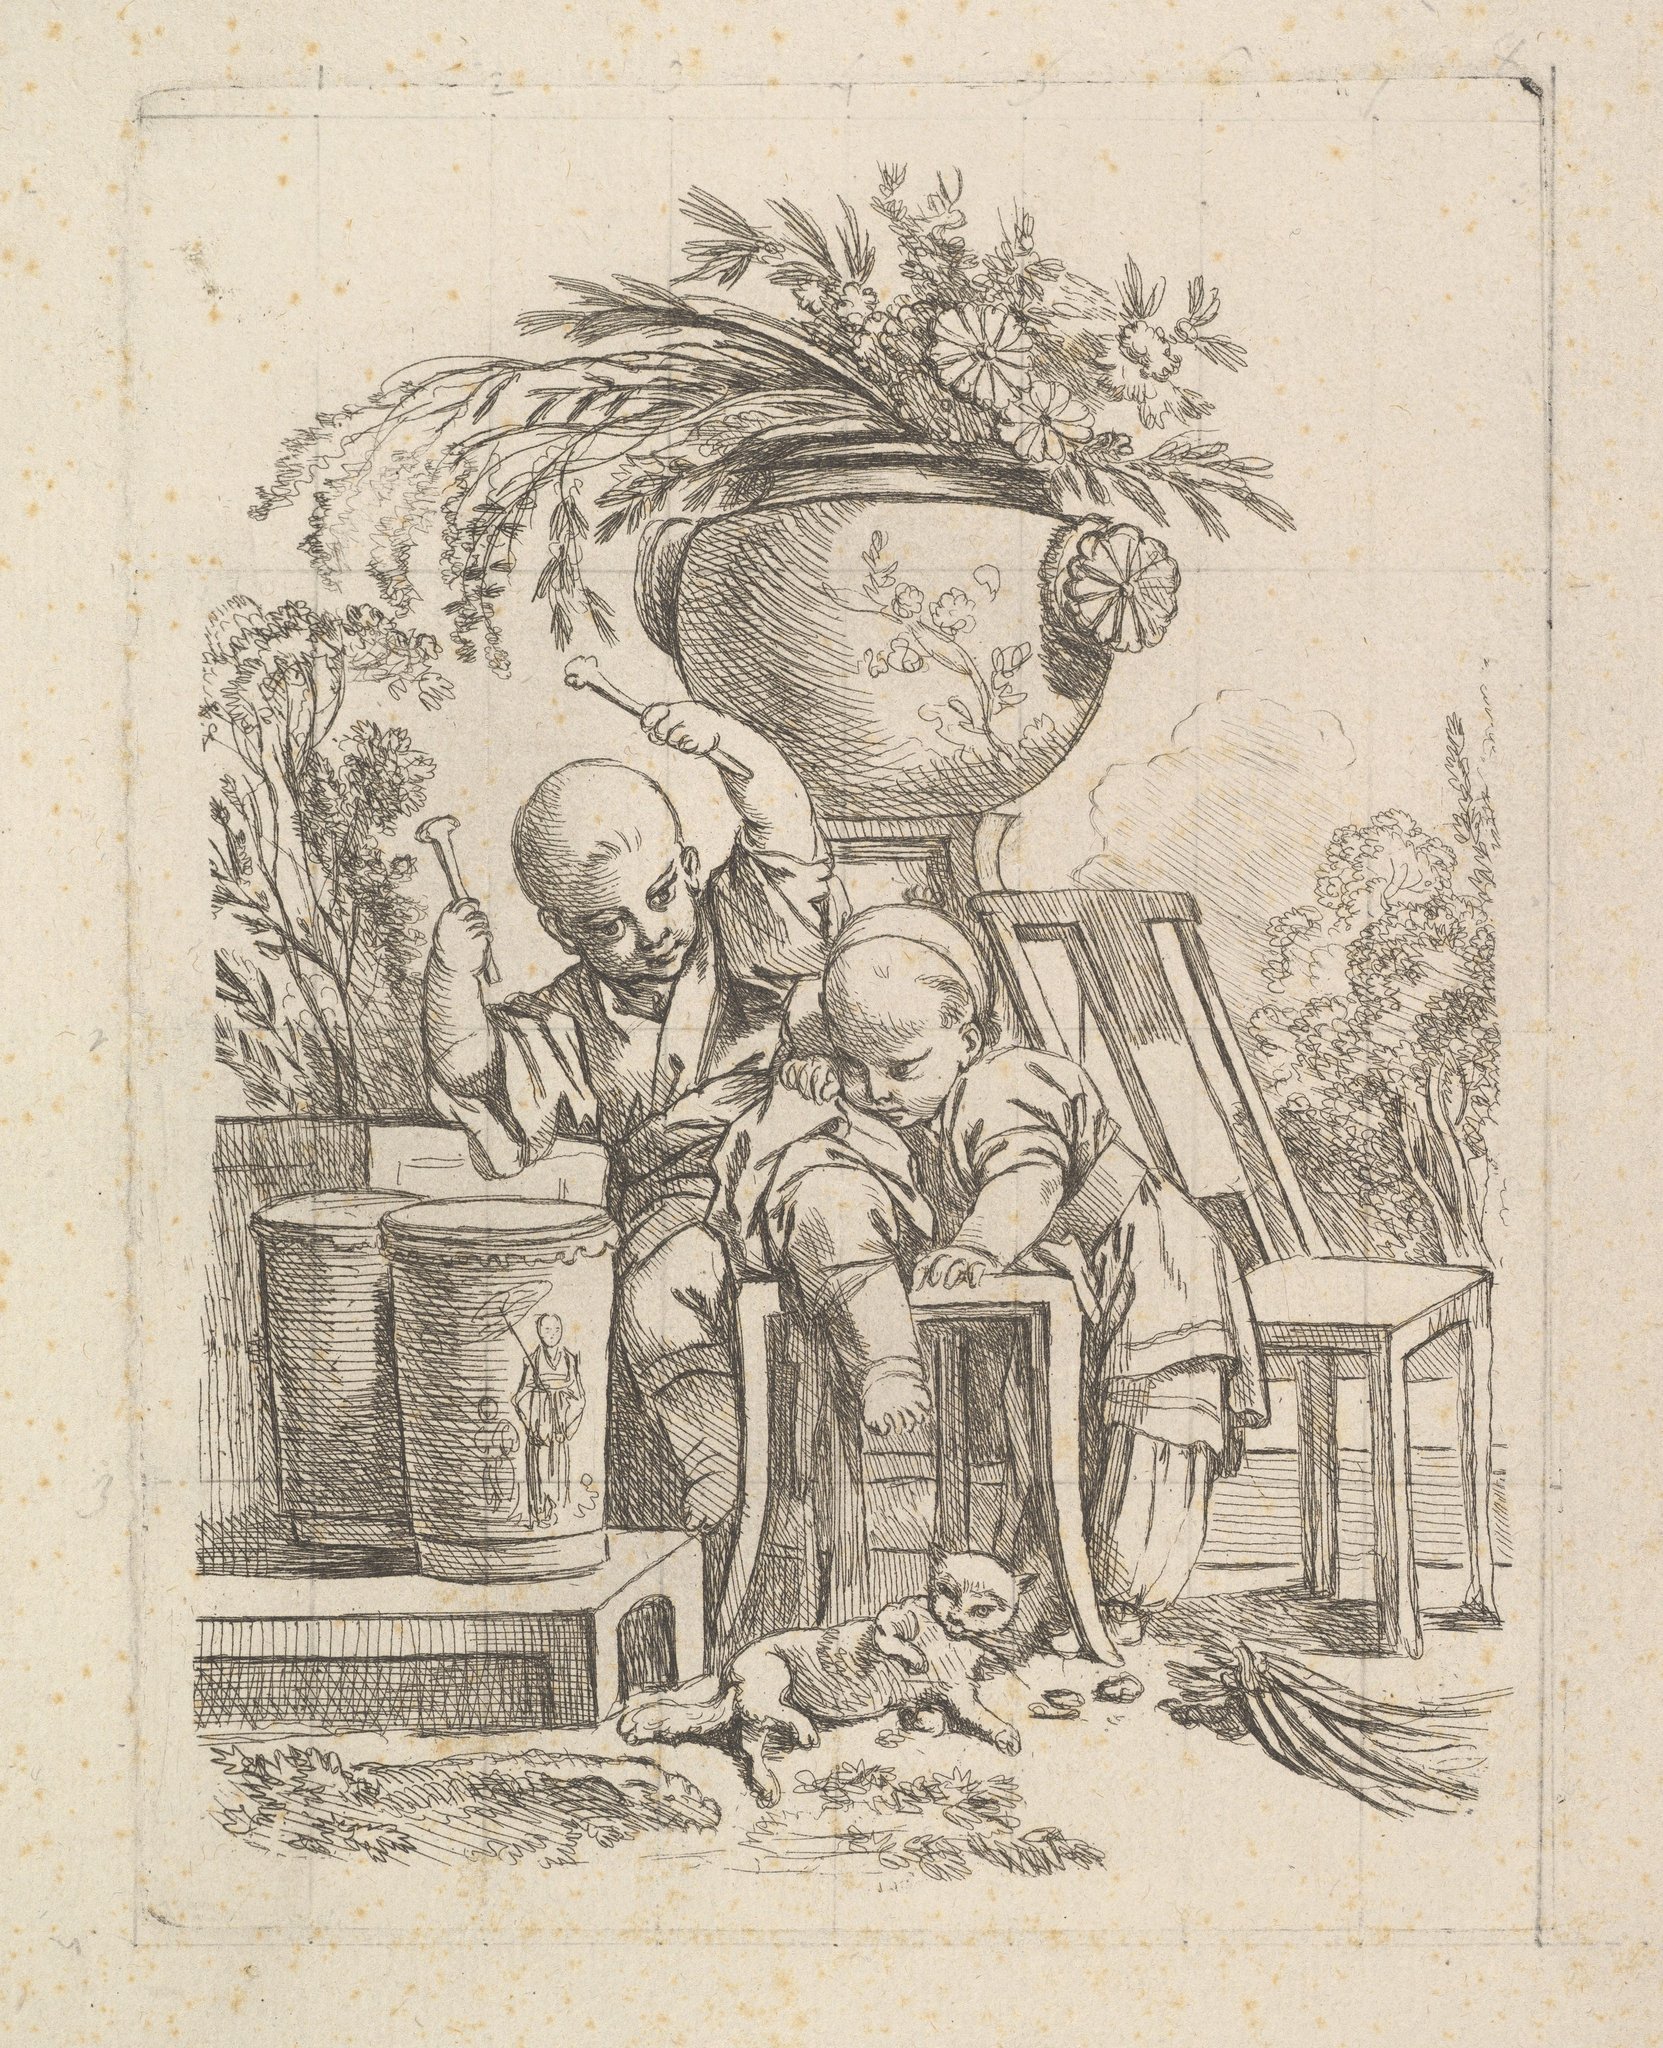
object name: print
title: Two Children, One Playing the Drum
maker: louis antoine crozat, baron de thiers, paris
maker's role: artist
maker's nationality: french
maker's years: 1699-1770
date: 1700-1770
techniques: engraving, etching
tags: children,drums